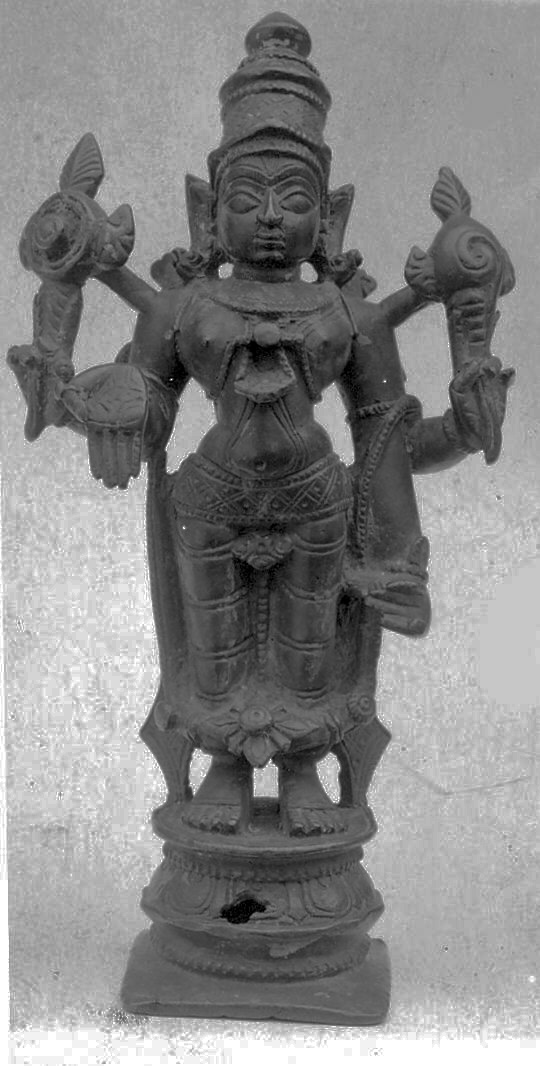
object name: figurine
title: Standing Vishnu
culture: indian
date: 1701-1900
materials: bronze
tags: vishnu,hinduism